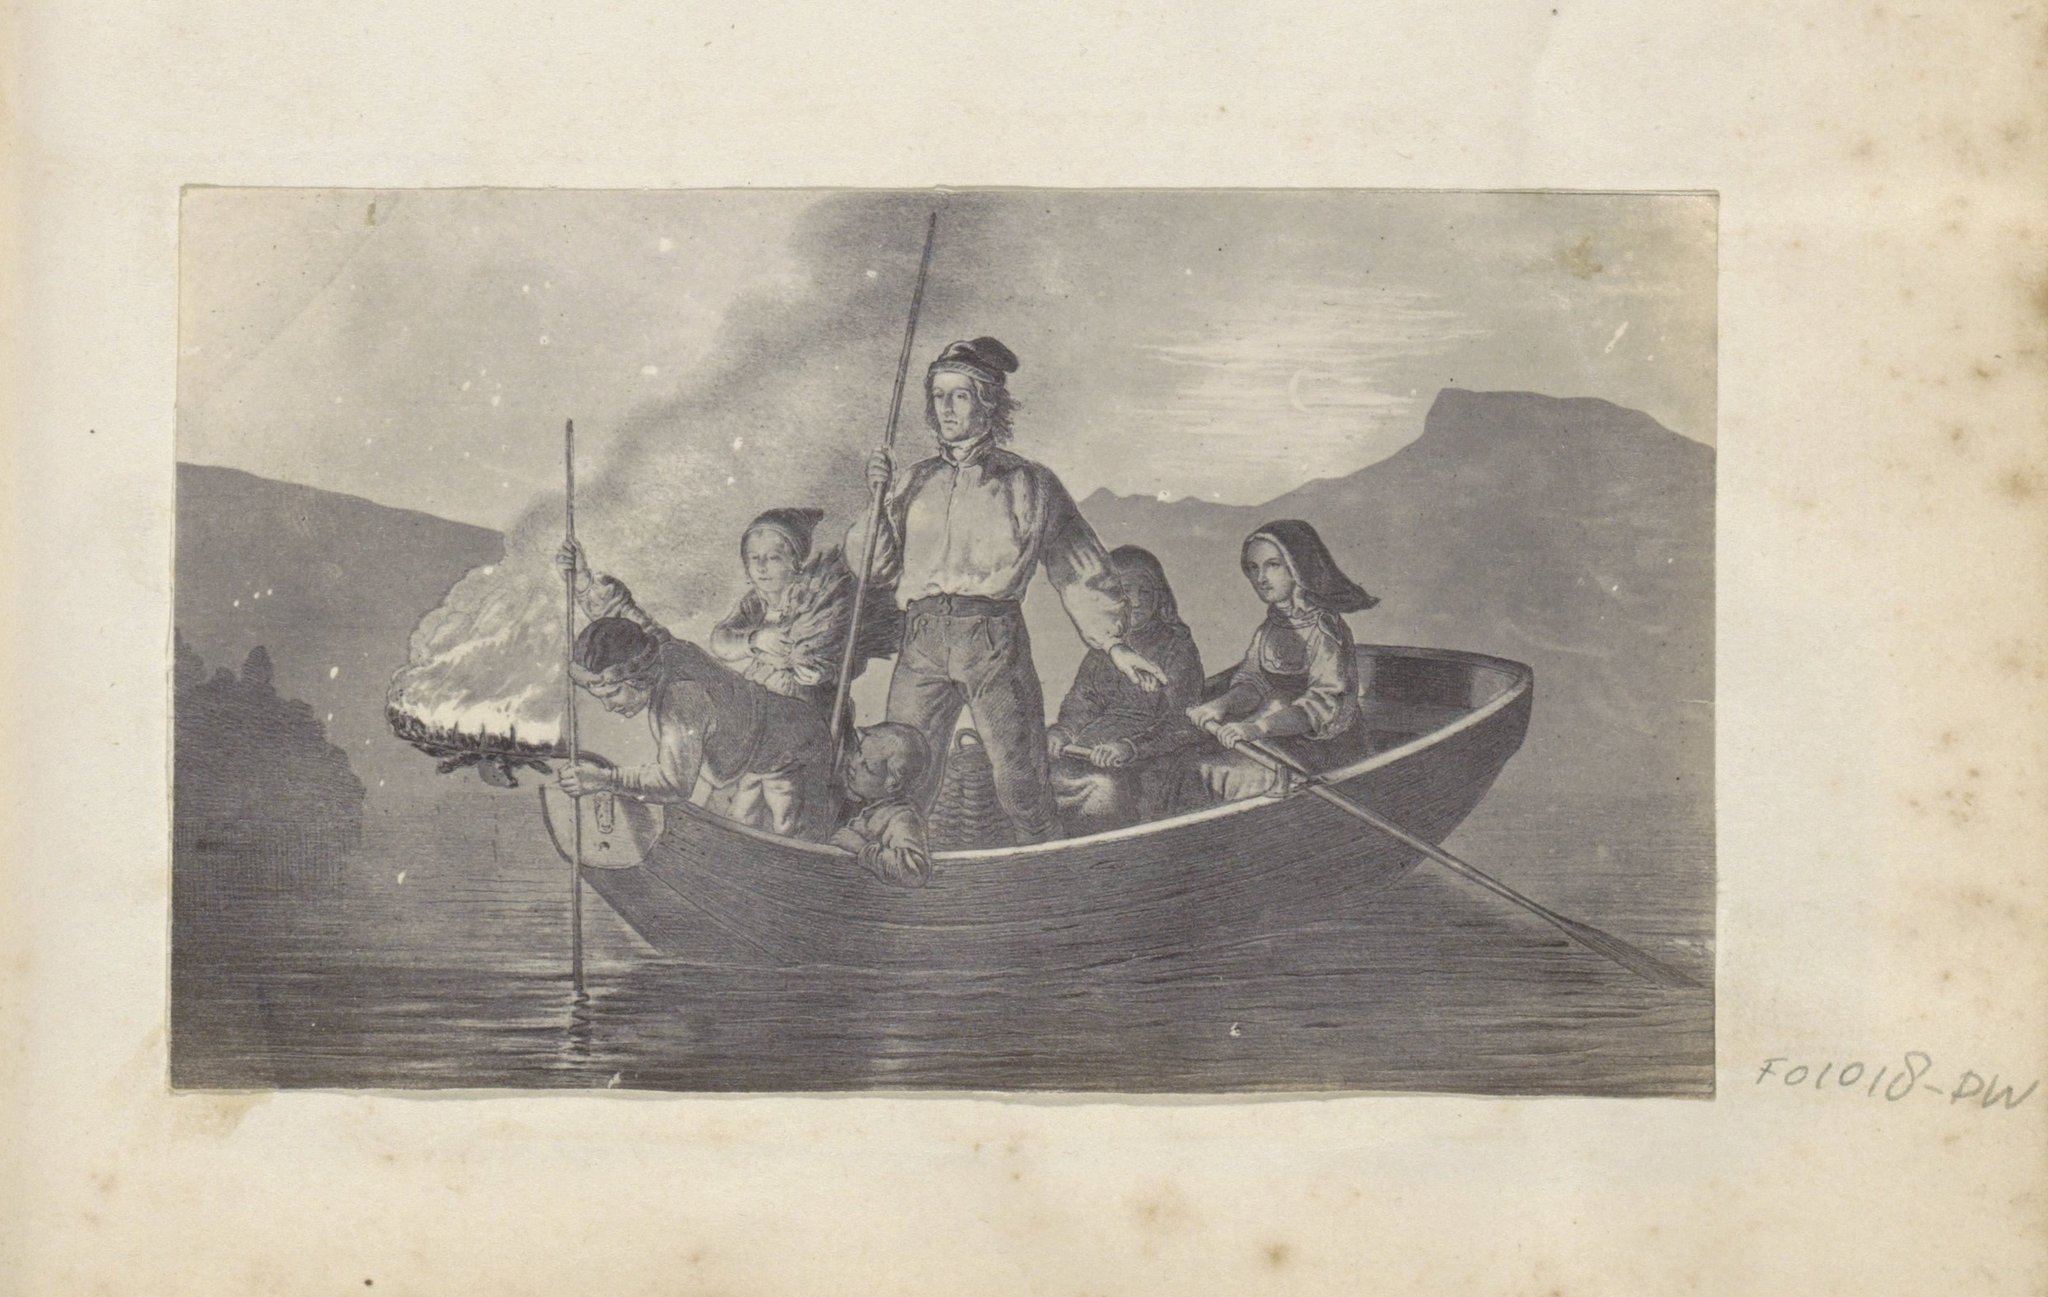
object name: reproduction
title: Fotoreproductie van (vermoedelijk) een prent naar een schilderij van Adolph Tidemand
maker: Anonymous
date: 1860-1870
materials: paper, photographic support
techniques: albumen print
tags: torch, rowing-boat, canoe, etc., fisherman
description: Onderdeel van Engels familiealbum met foto's van personen, reizen, cricket en kunstwerken.